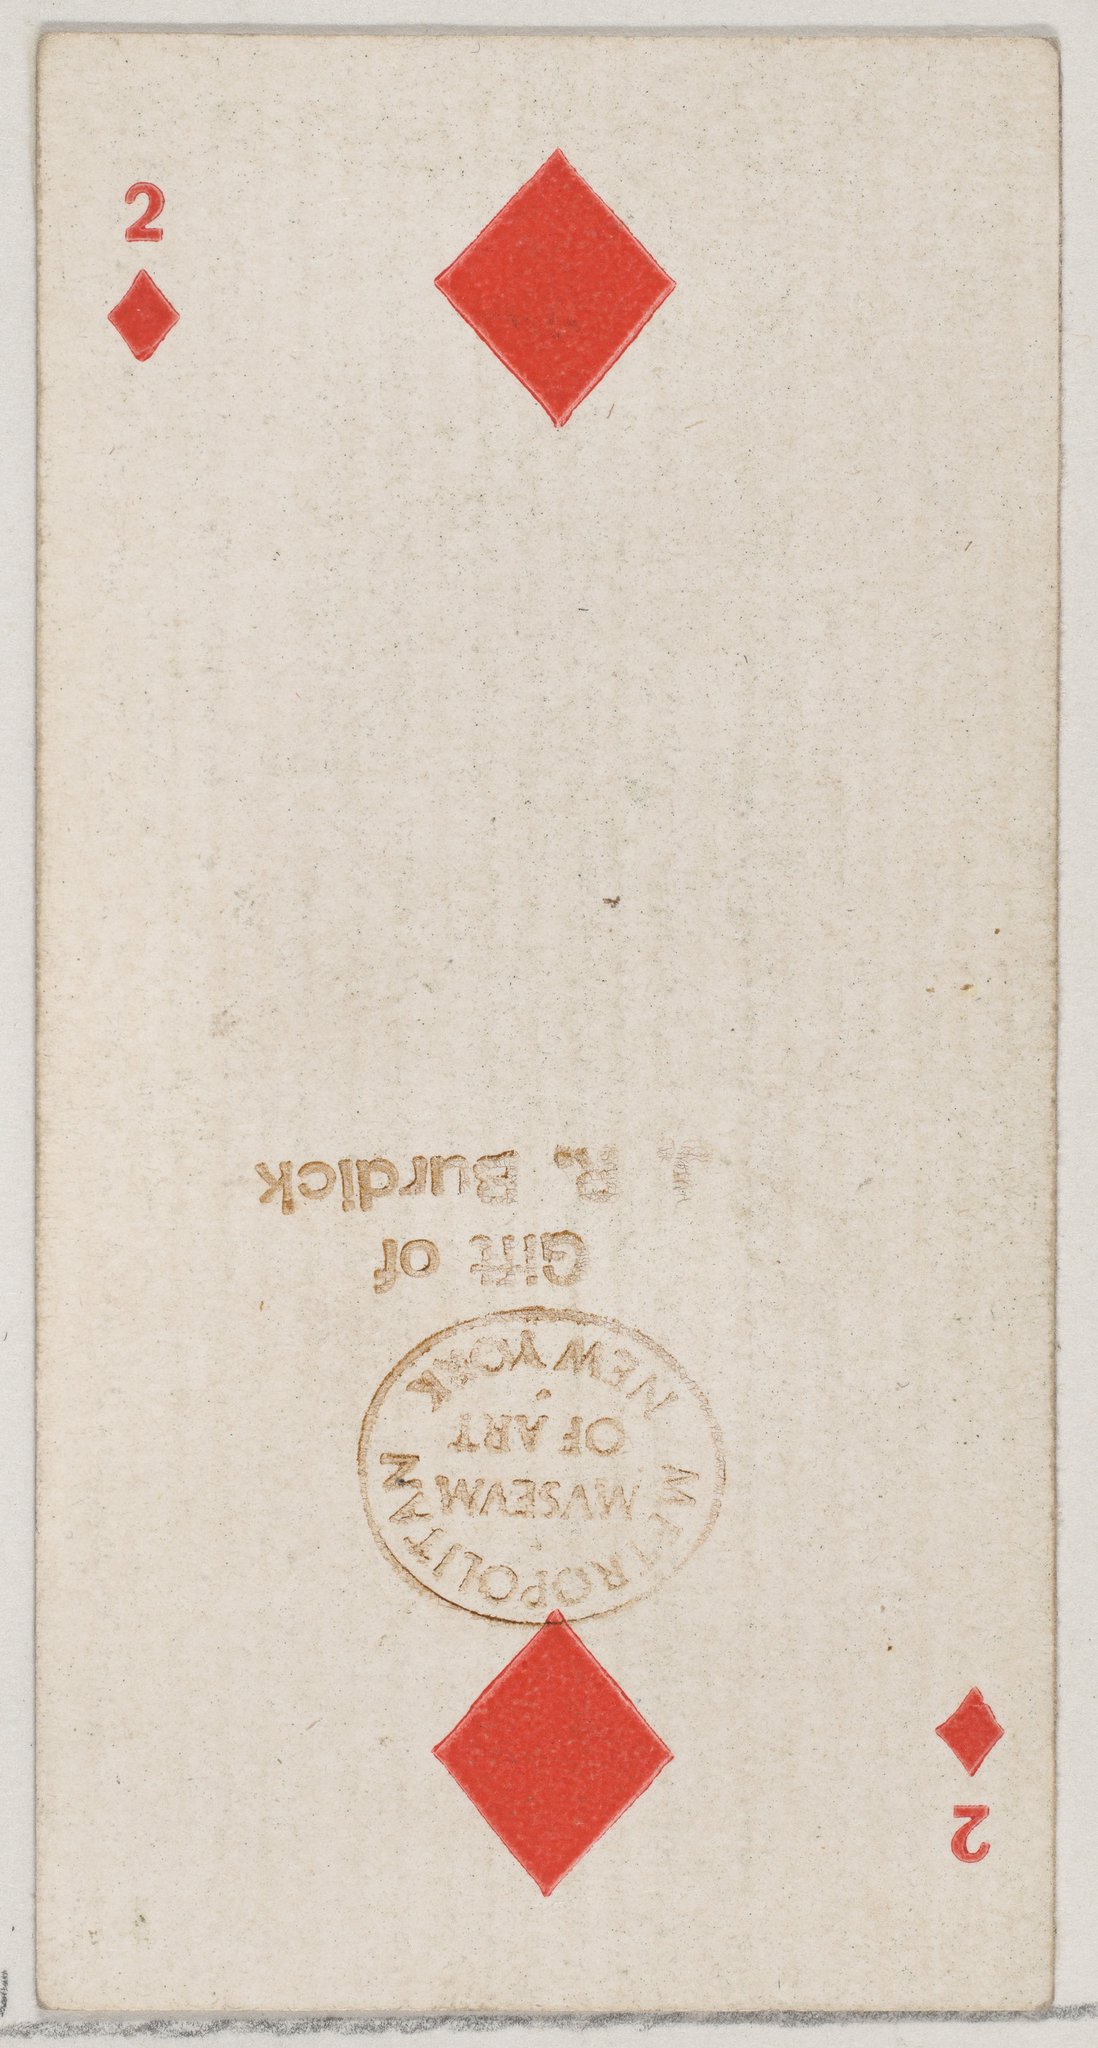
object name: print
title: Two Diamonds (red), from the Playing Cards series (N84) for Duke brand cigarettes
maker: w. duke, sons & co.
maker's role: publisher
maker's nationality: american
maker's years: 1870-1920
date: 1888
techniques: color lithograph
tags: playing cards